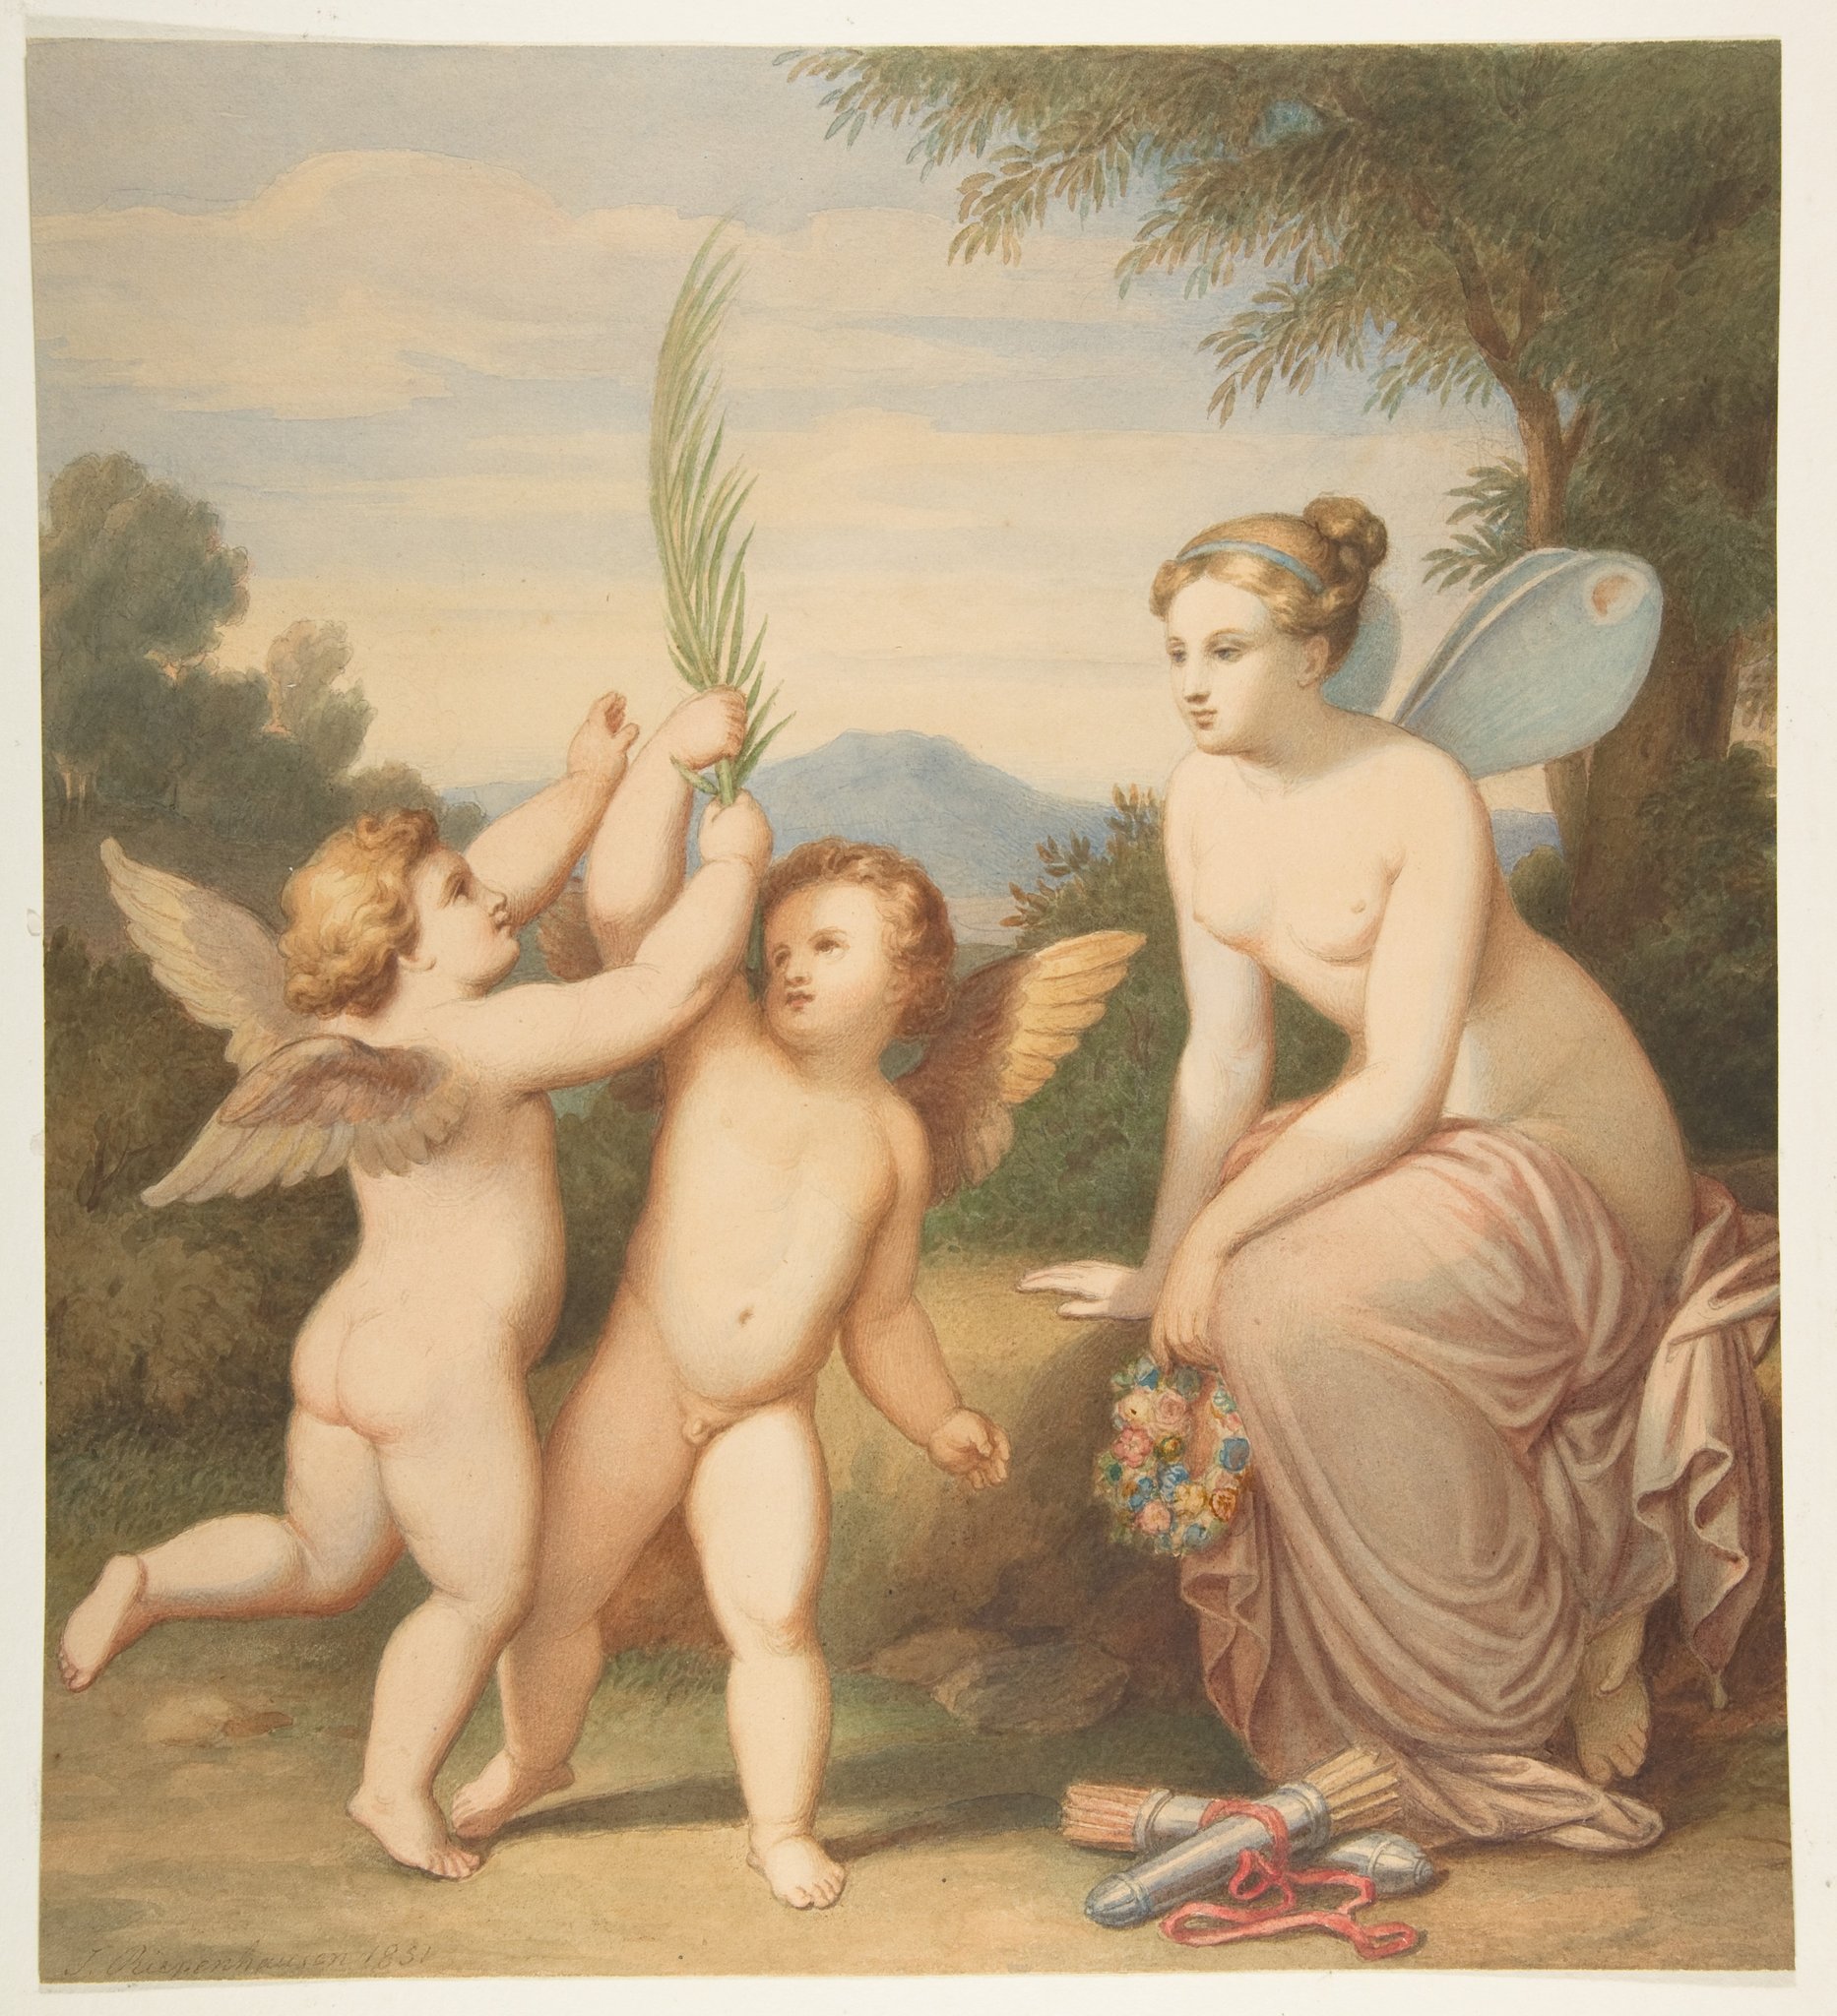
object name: drawing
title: Eros and Anteros with Psyche Looking at Them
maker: johannes riepenhausen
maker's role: artist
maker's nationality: german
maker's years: 1788-1860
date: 1810-1860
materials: chalk, watercolor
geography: germany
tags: female nudes,eros,psyche